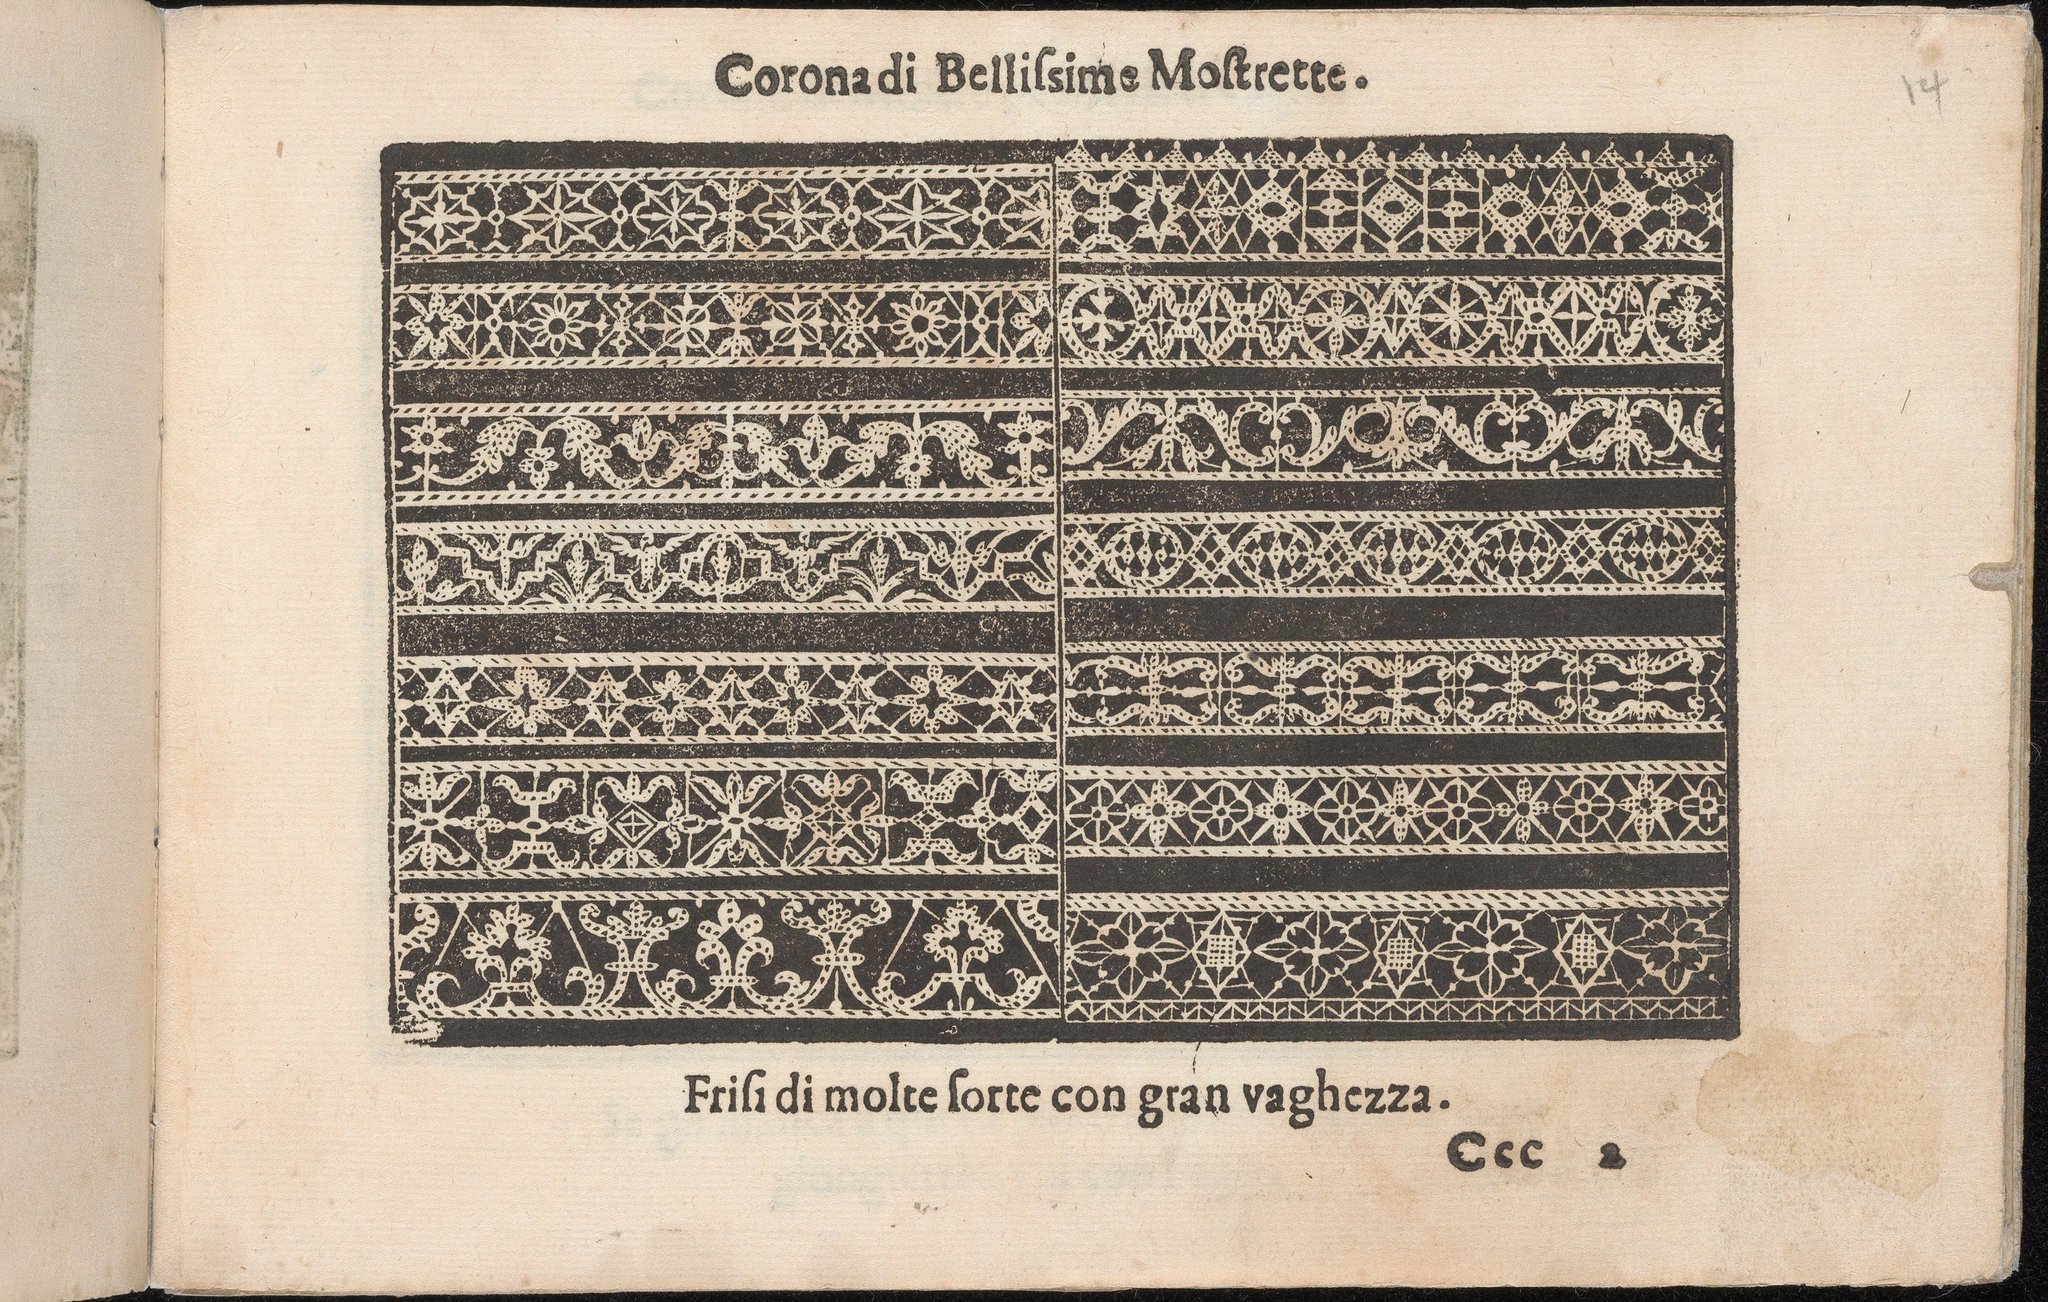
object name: book print ornament architecture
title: Corona delle Nobile et Virtuose Donne, Libro Terzo, page 14 (recto)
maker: cesare vecellio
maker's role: designer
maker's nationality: italian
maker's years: 1521-1601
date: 1620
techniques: woodcut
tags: ornament